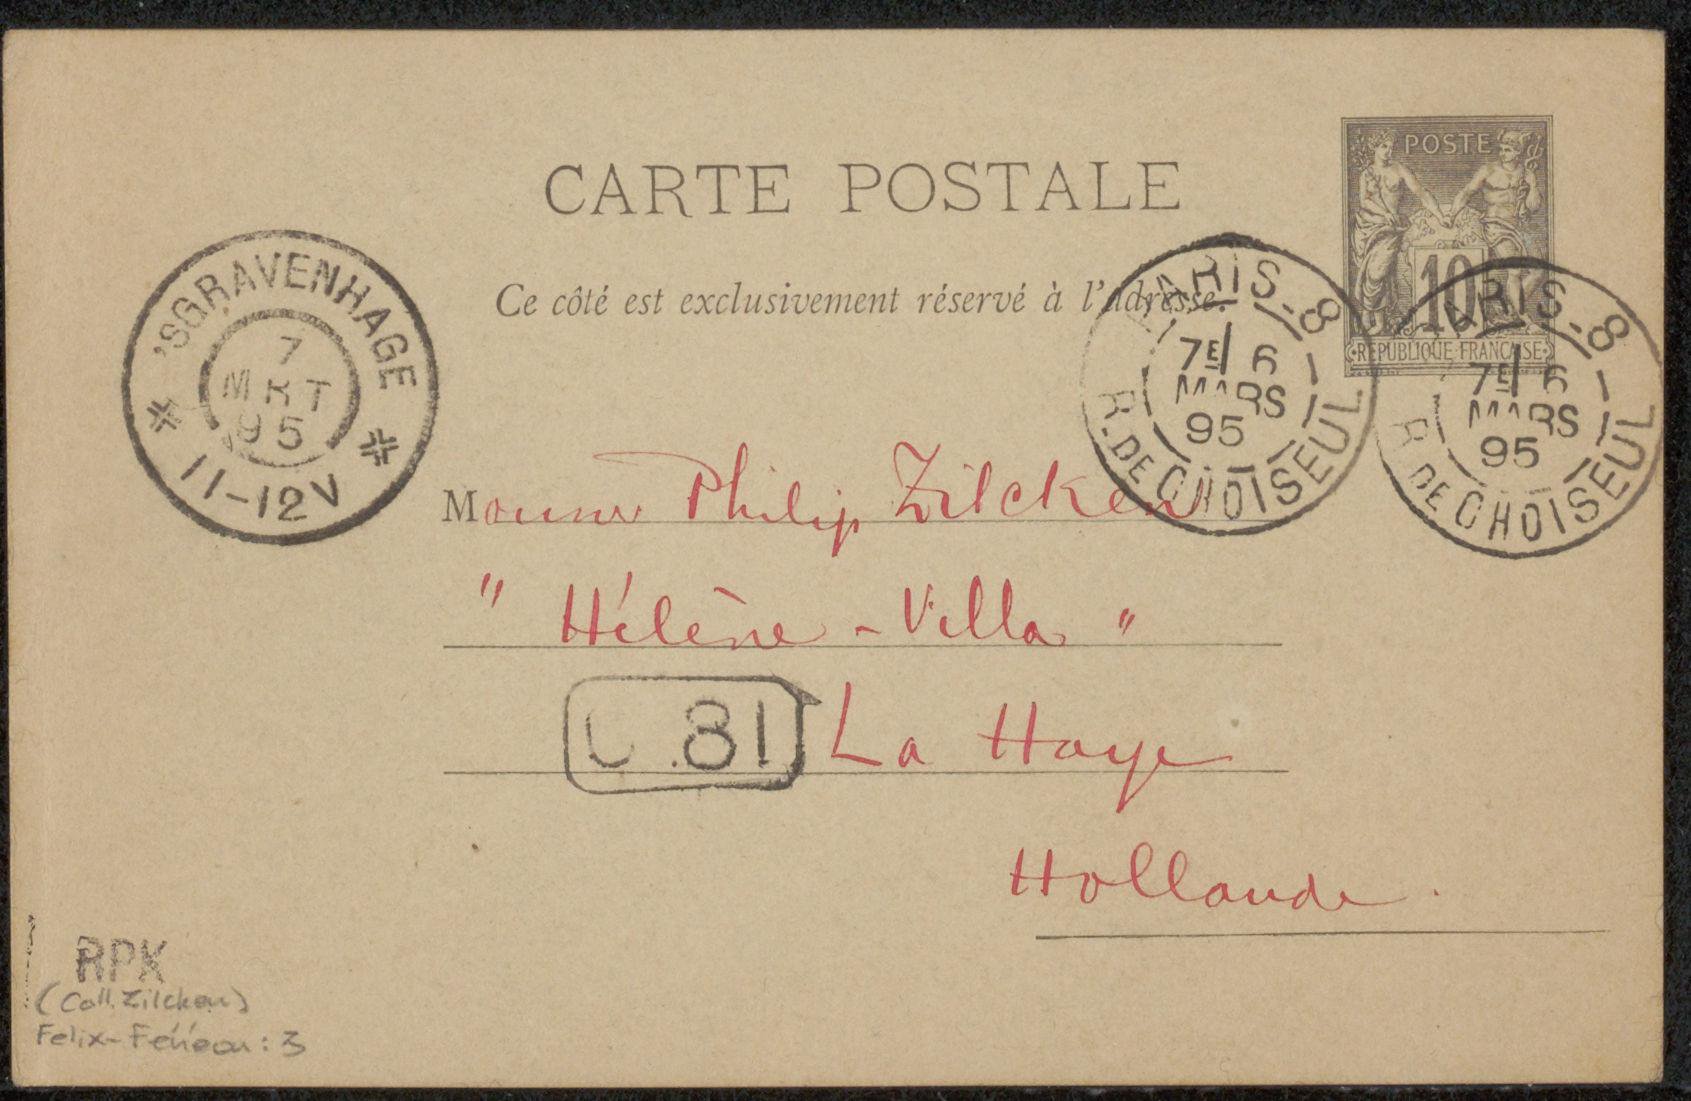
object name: postcard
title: Briefkaart aan Philip Zilcken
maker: félix fénéon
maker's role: handelaar, kunstcriticus, verzamelaar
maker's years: 1861-1944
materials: cardboard, ink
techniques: pen, writing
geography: paris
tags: the hague, painter, draughtsman, philip zilcken, literature ~ arts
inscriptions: collector's mark: ‘RPK’